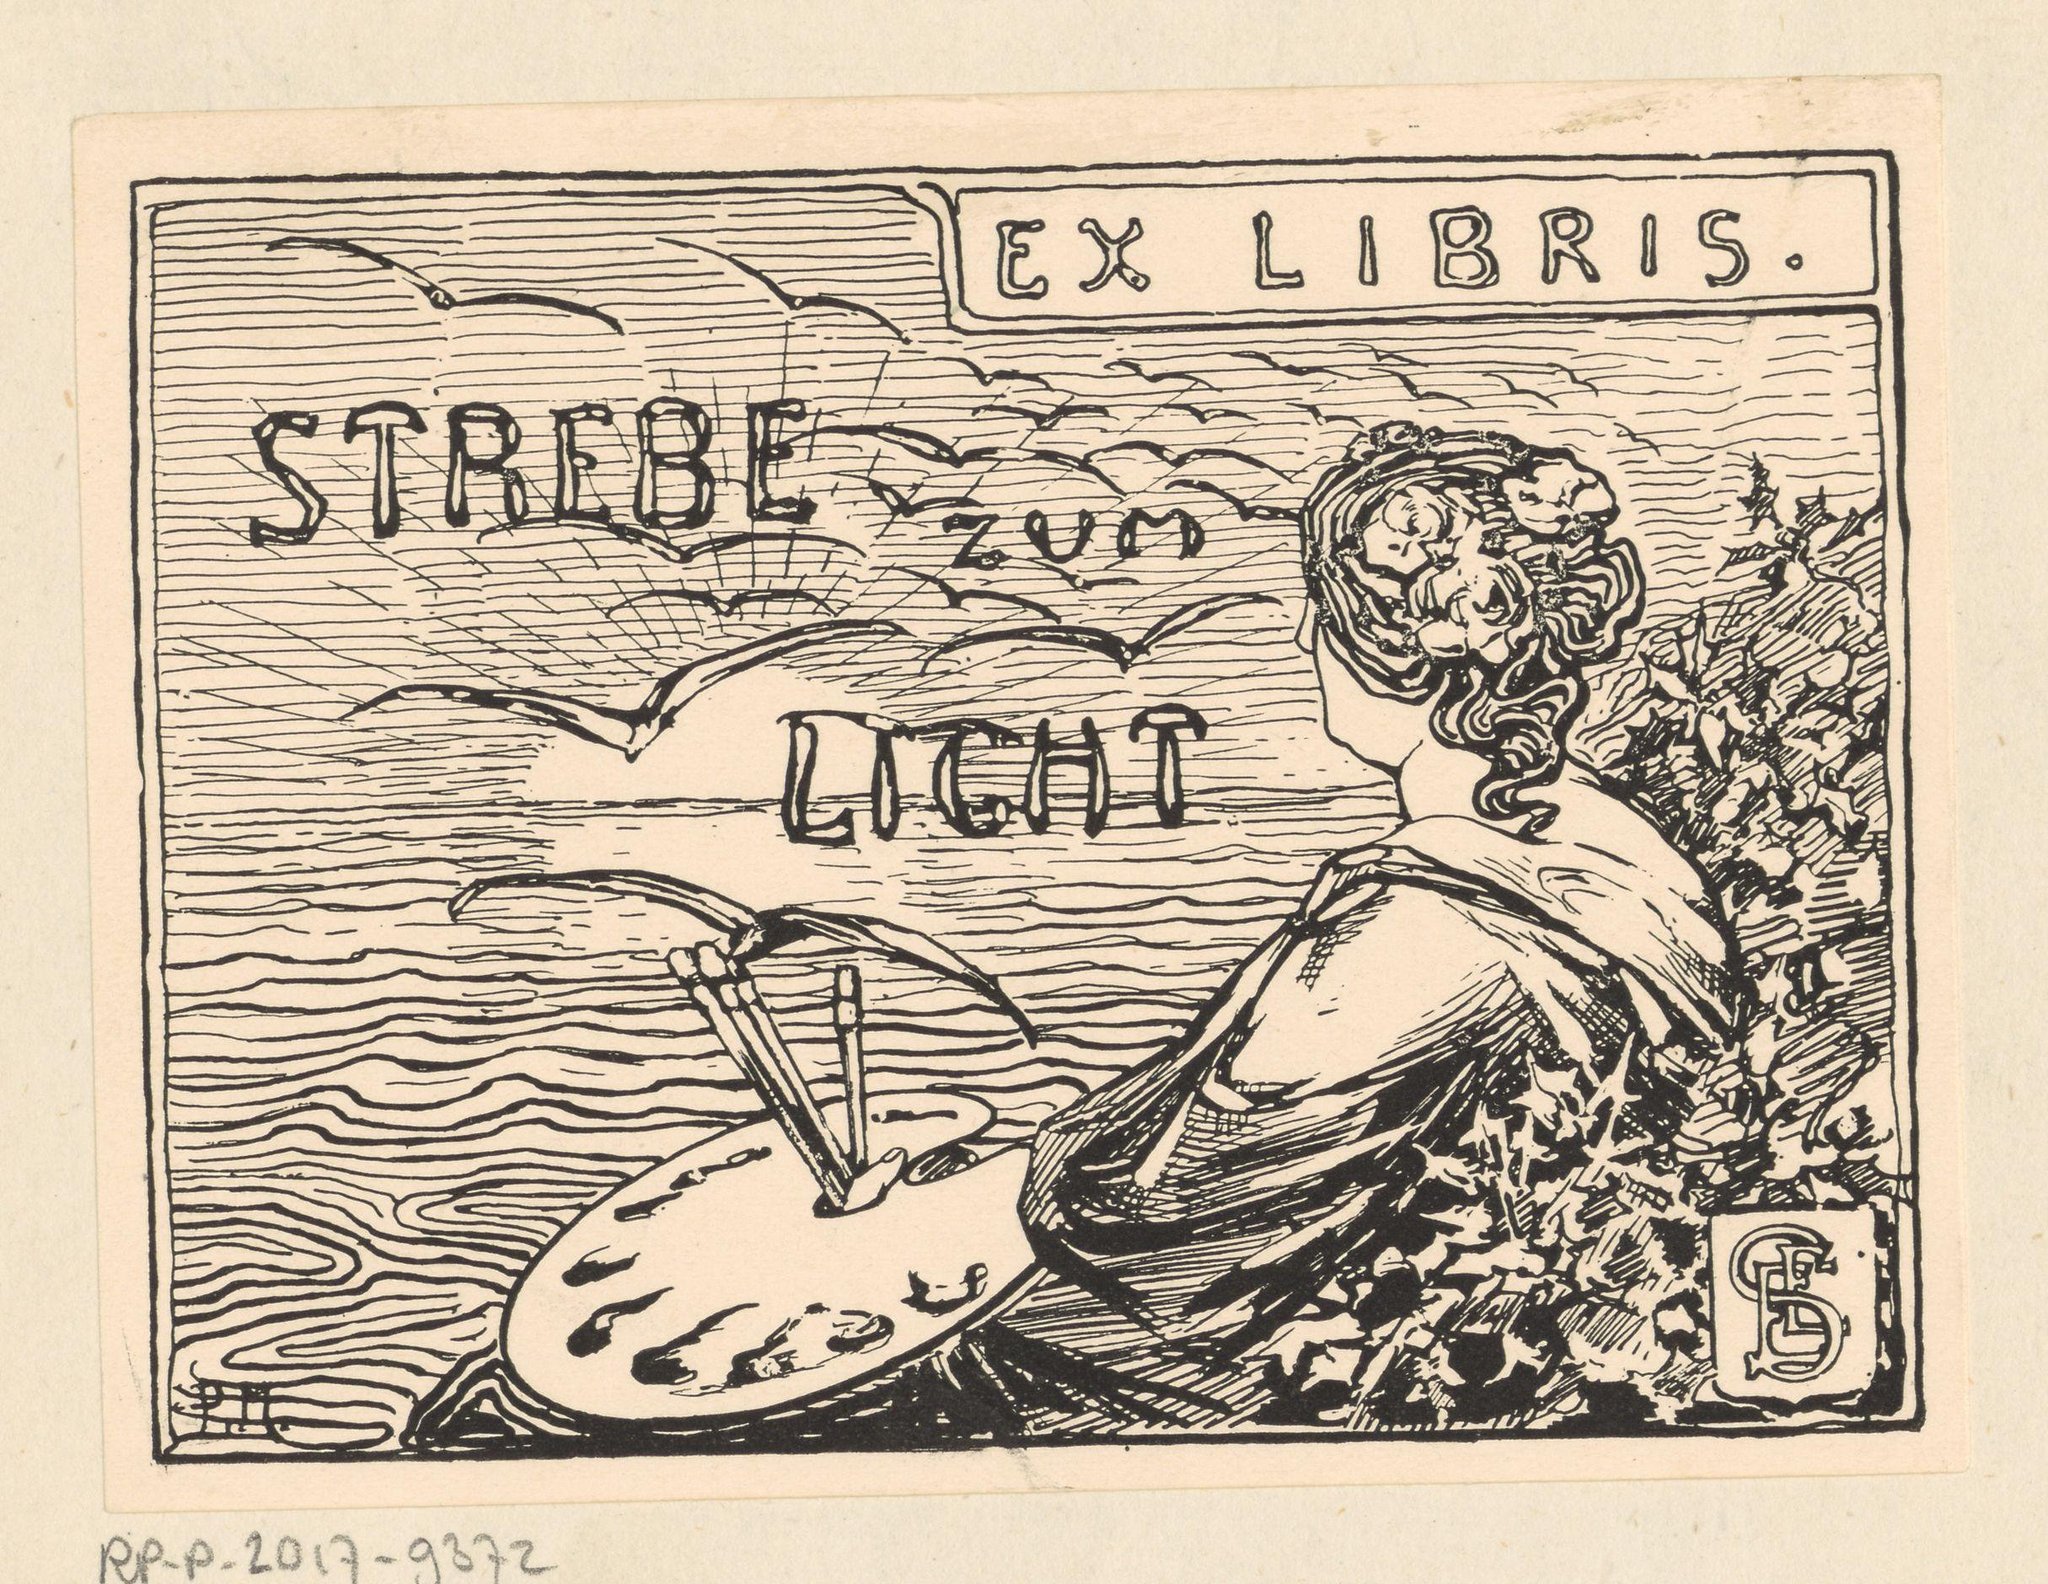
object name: bookplate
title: Ex libris van Eva Emmelina Seelig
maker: piet mondriaan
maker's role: print maker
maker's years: 1872-1944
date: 1882-1930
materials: paper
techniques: lithograph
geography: netherlands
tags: amsterdam, painter, draughtsman, sitting figure - aa - female human figure, sea (seascape), palette